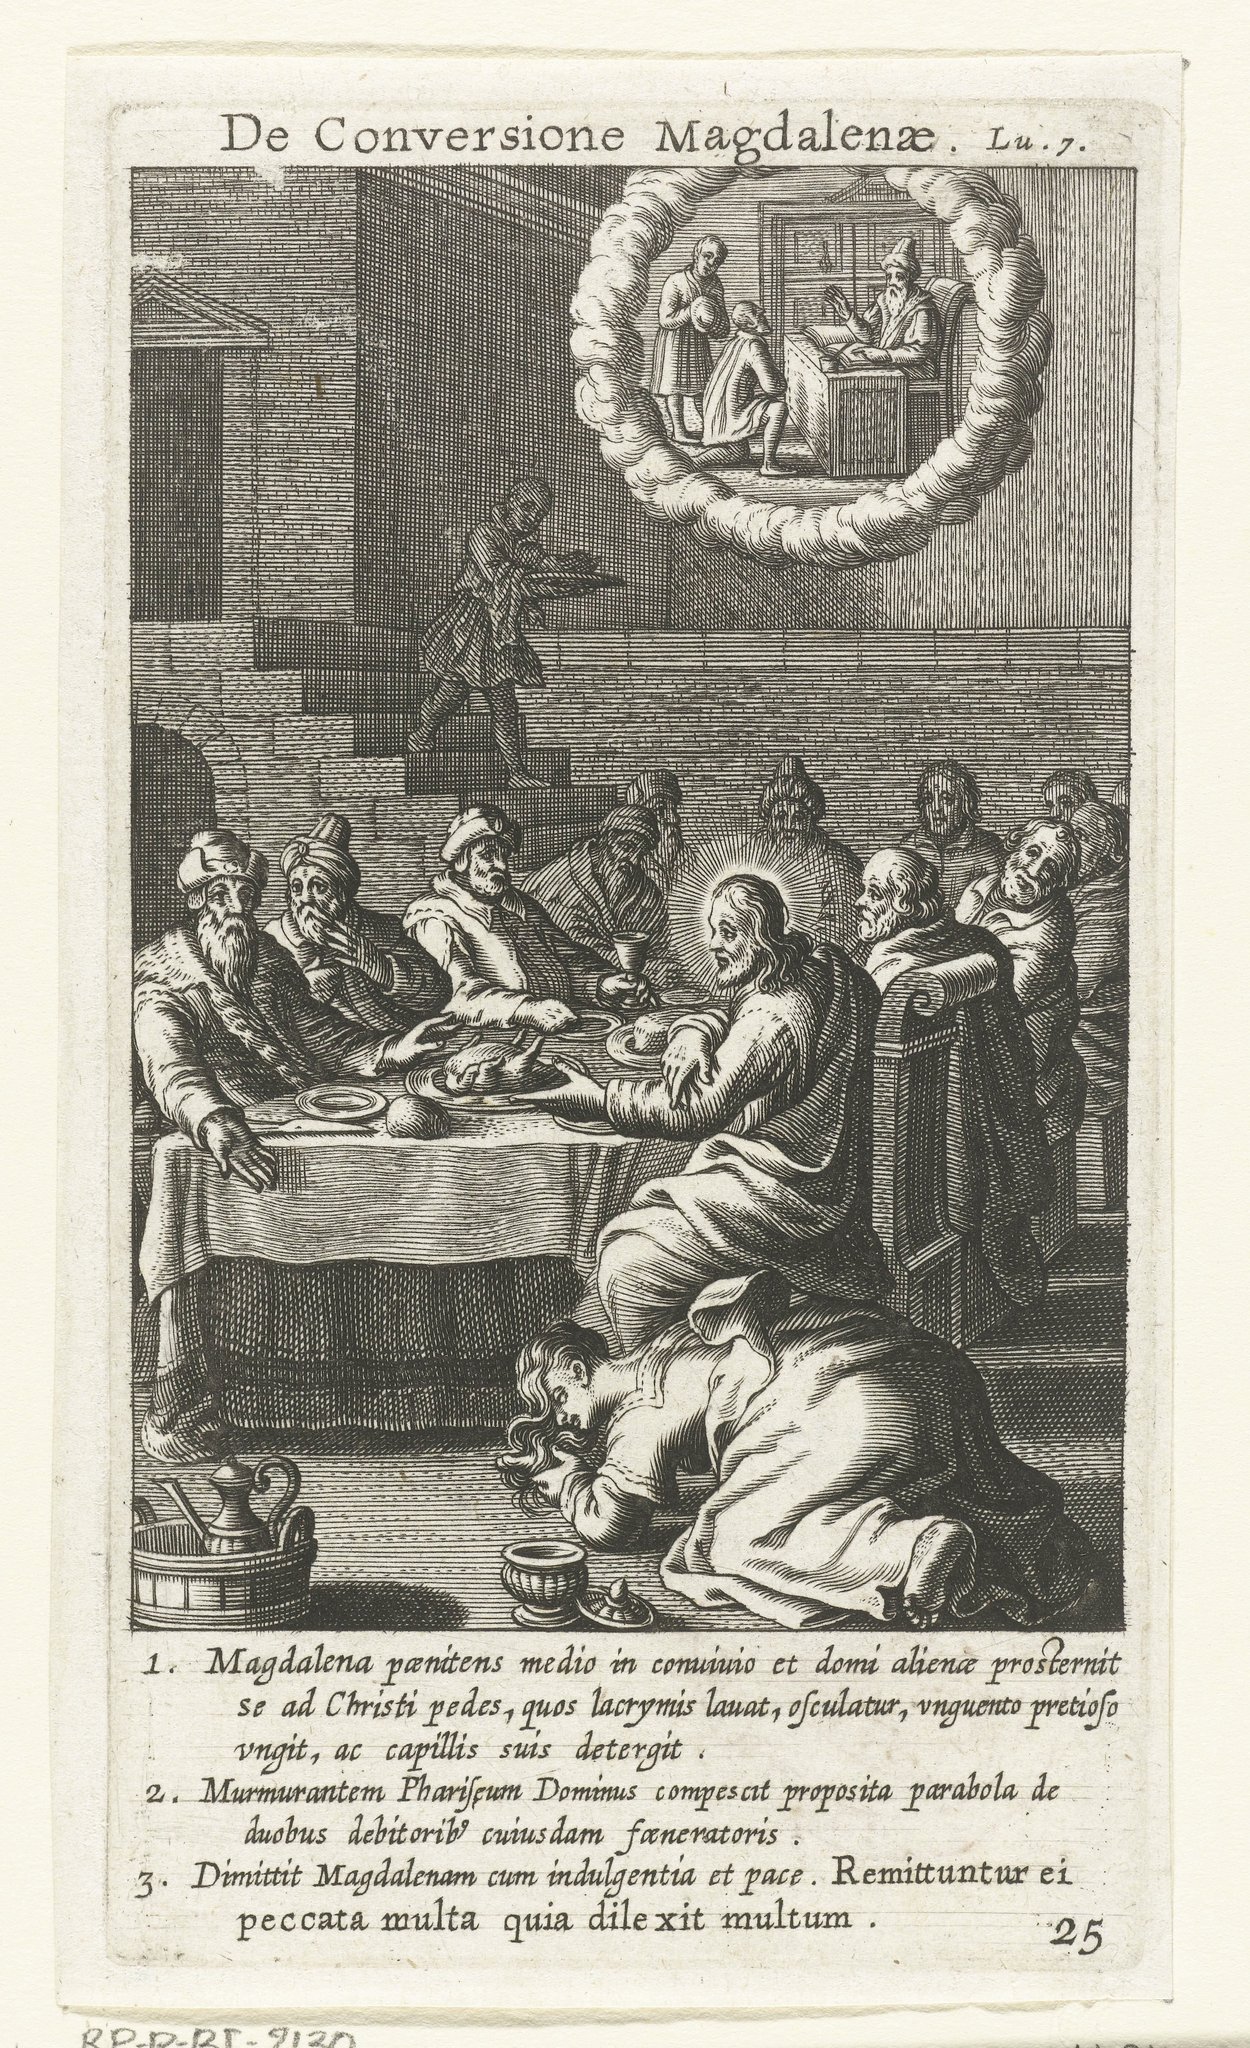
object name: print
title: Vitae passionis et mortis Jesu Christ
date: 1590-1622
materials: paper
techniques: engraving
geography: antwerp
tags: a woman washes christ's feet with her tears, and wipes them with her hair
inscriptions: collector's mark: Lugt 240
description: Prent uit: Joannes Bourgois, Vitae passionis et mortis Jesu Christi Somini nostri mysteria, Antwerpen Hendrick Aertssens, 1622, afb. 25